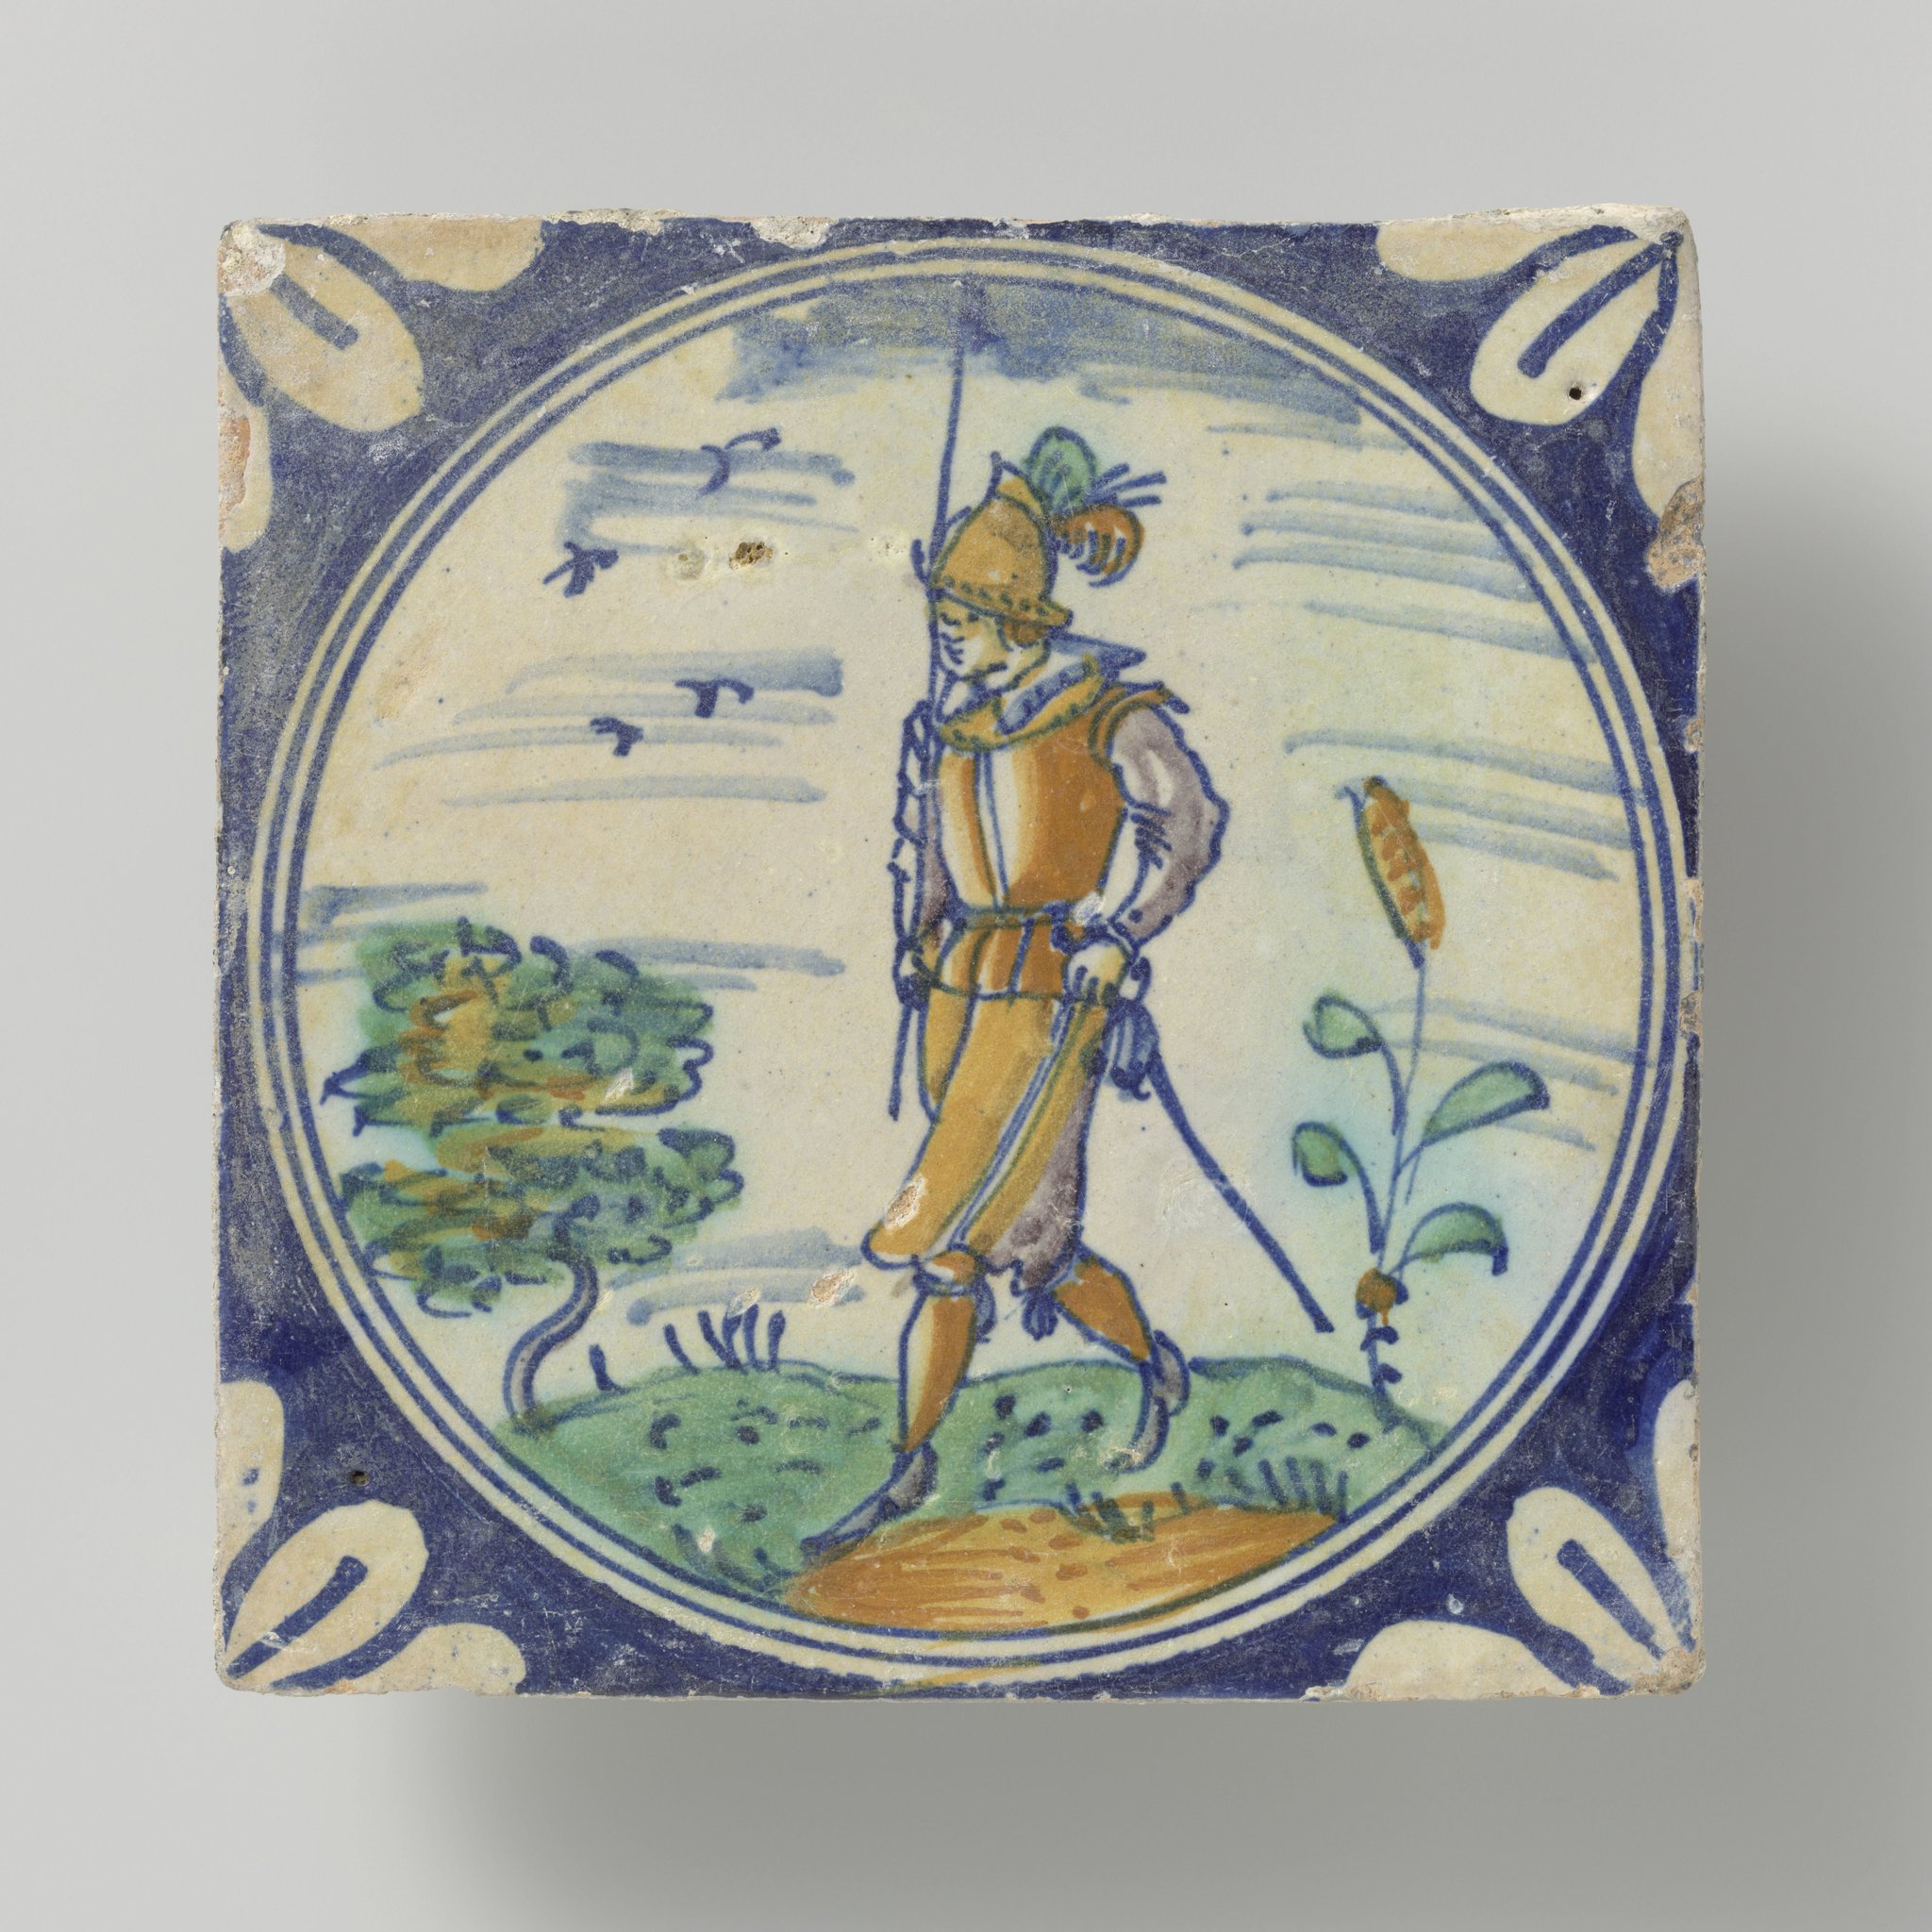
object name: tile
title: Tegel, veelkleurig beschilderd met een soldaat of een vaandeldrager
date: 1625-1700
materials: earthenware, glaze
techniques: maiolica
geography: netherlands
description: Tegel, veelkleurig beschilderd met een soldaat of een vaandeldrager.